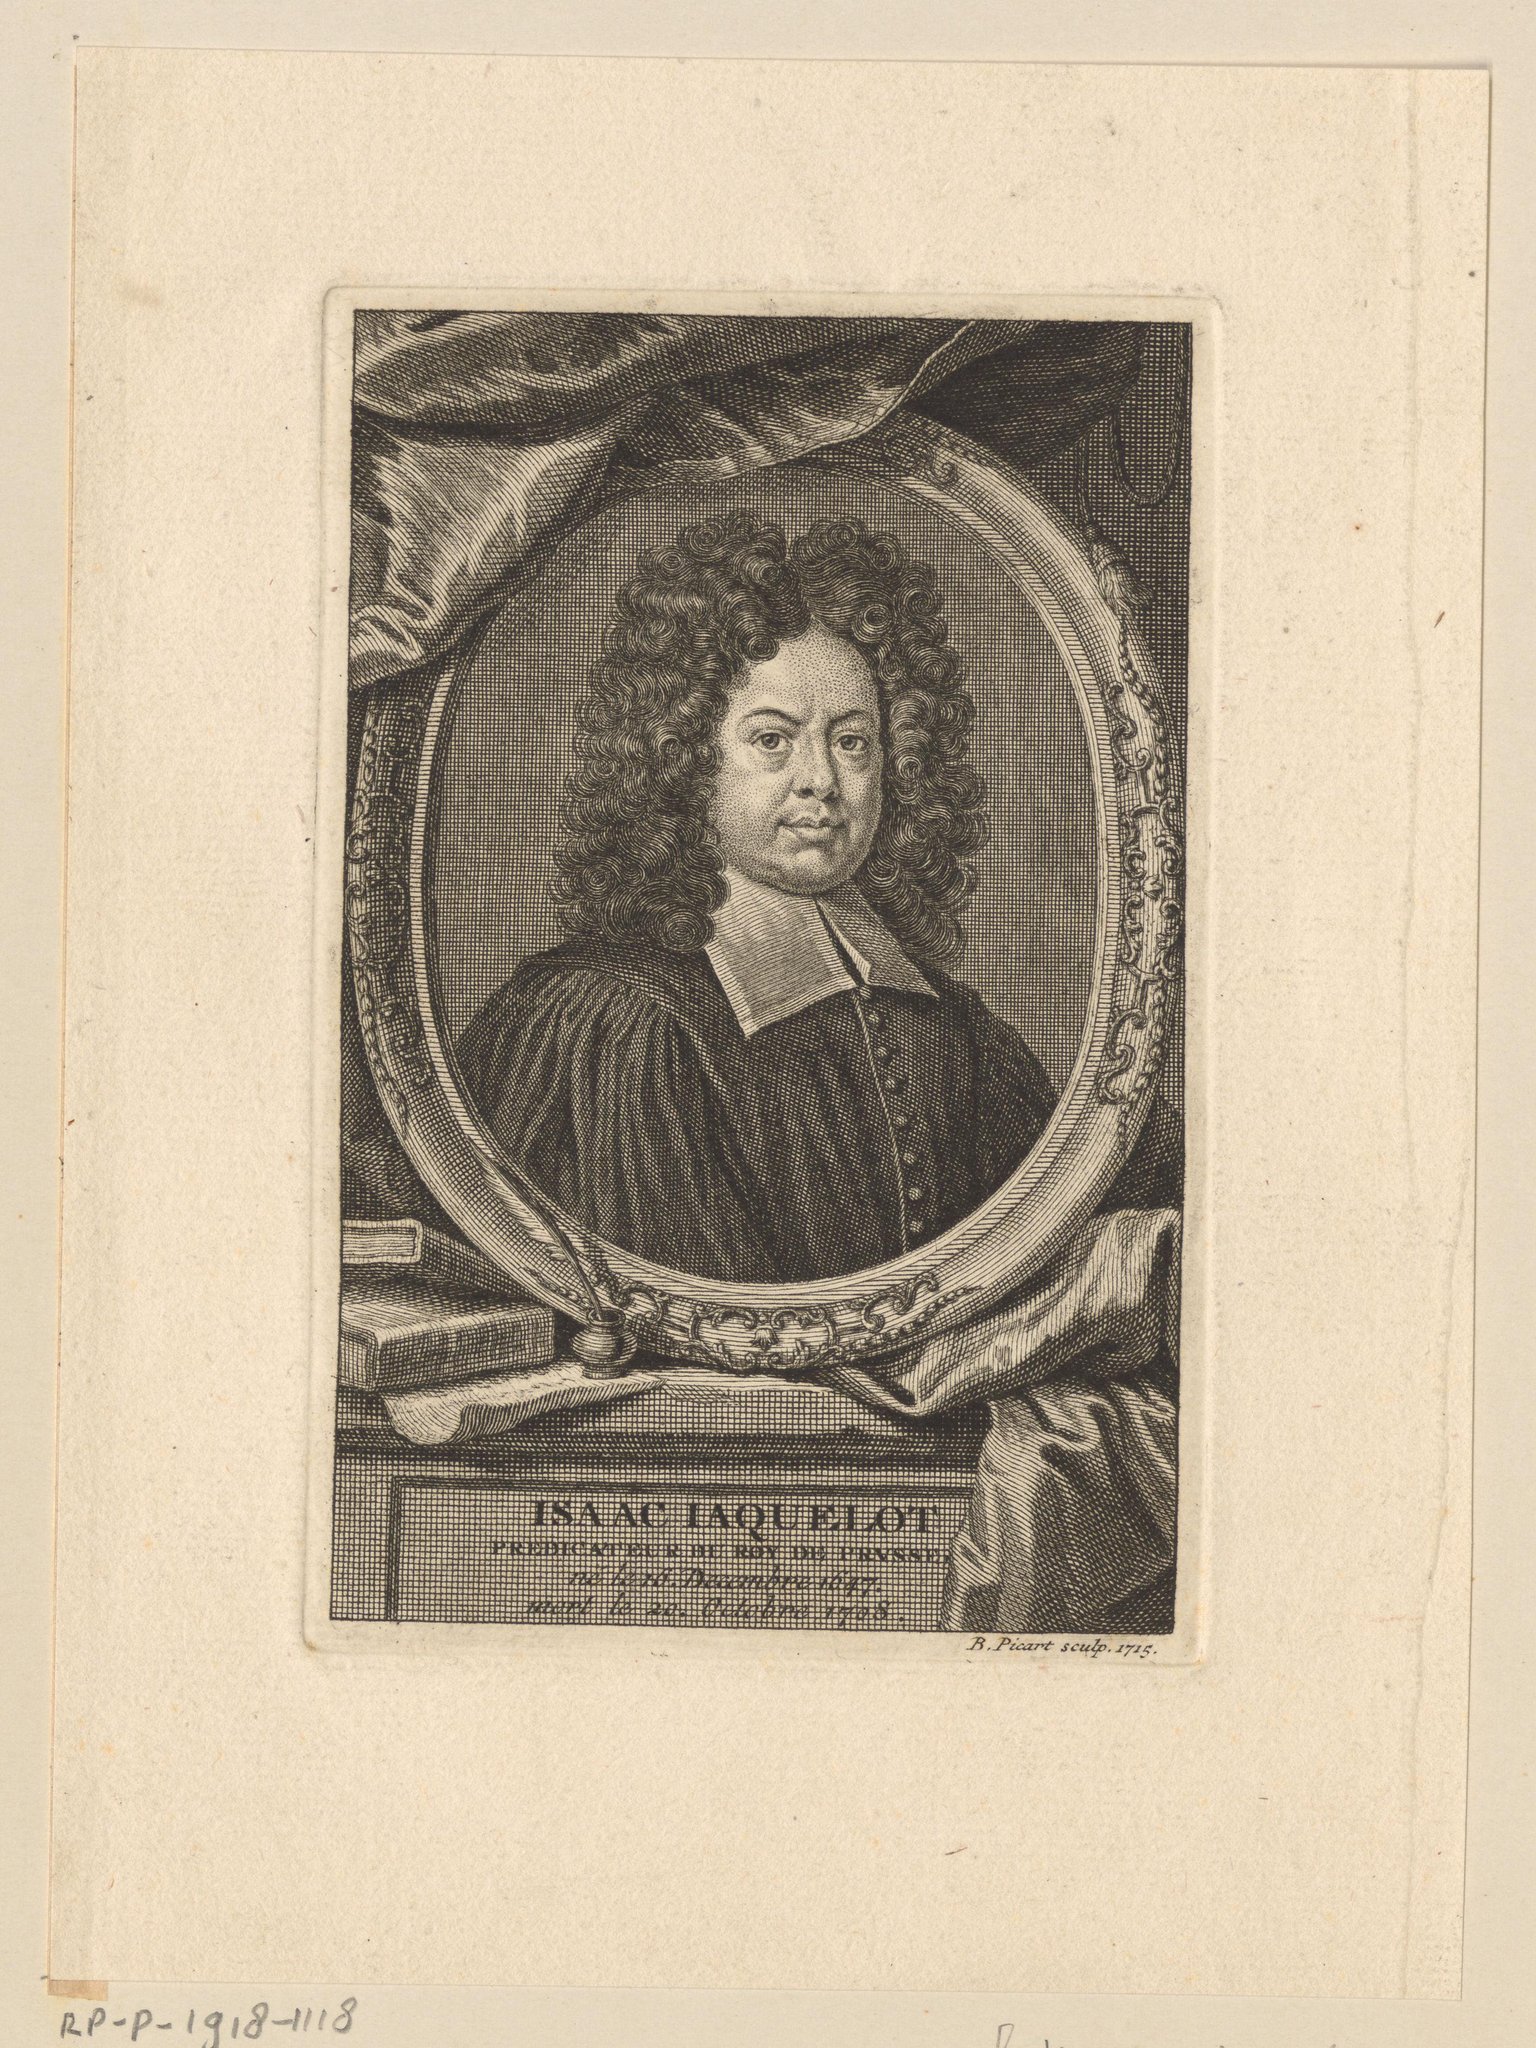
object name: print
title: Portret van Isaac Jacquelot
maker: bernard picart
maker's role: draughtsman, print maker, publisher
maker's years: 1673-1733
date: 1715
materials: paper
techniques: engraving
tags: theologian, historical persons, book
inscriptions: collector's mark: Lugt 2233